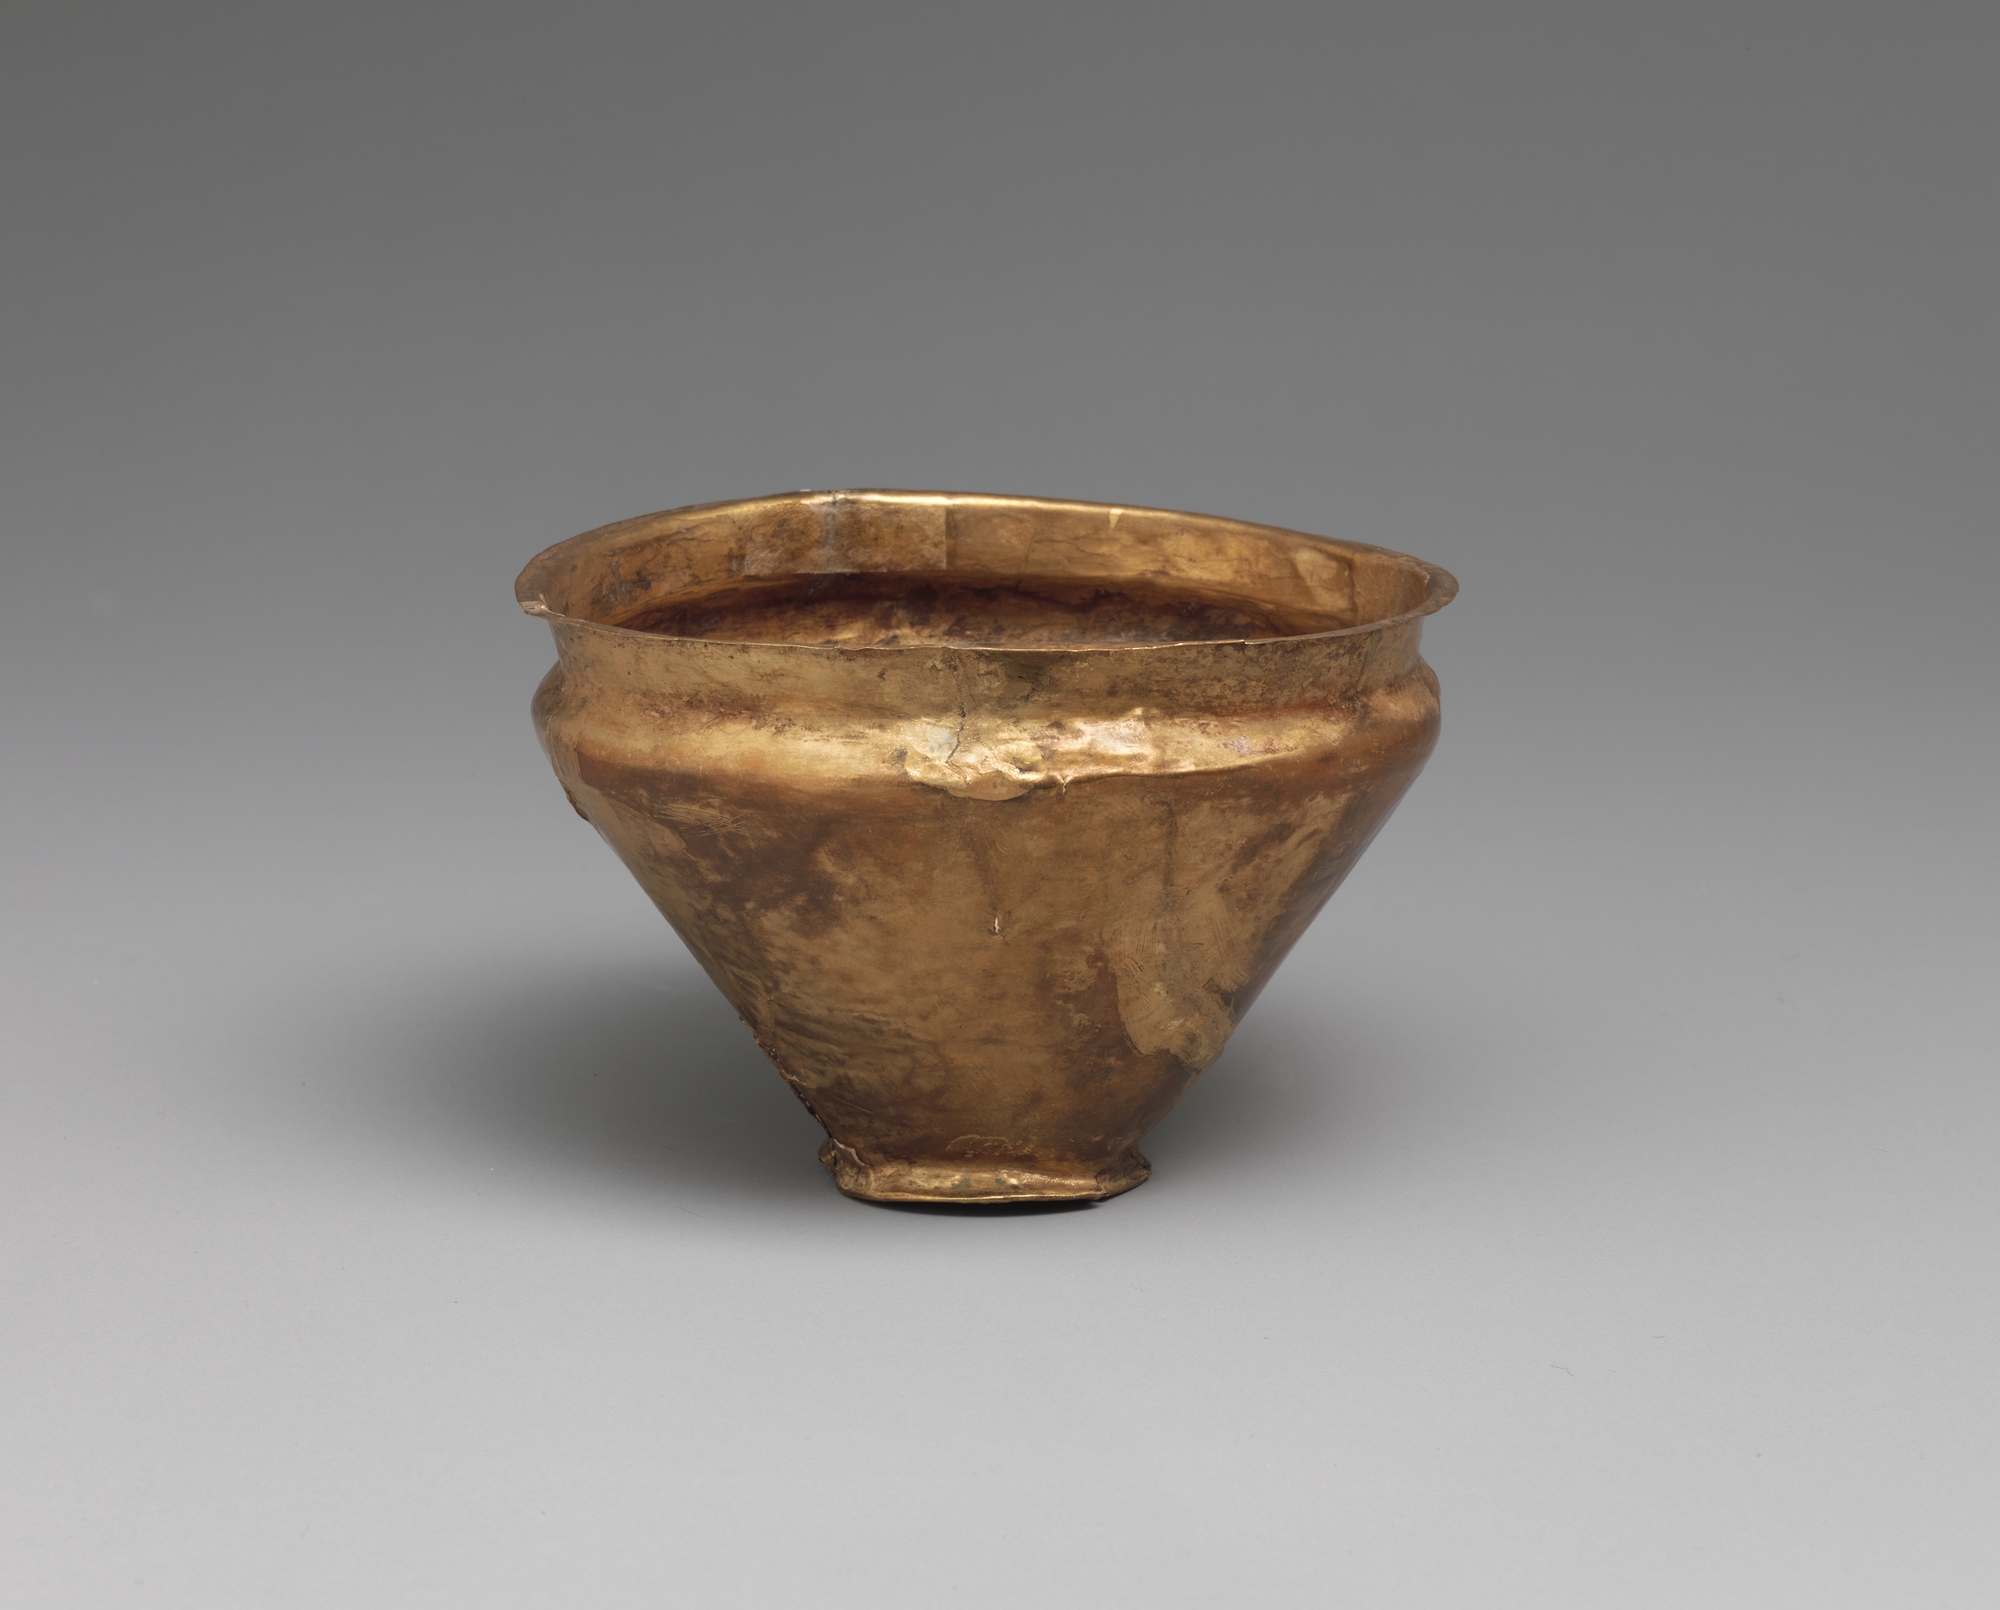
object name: cup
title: Gold cup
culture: aegean, helladic or mycenaean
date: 1550-1500 BCE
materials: gold